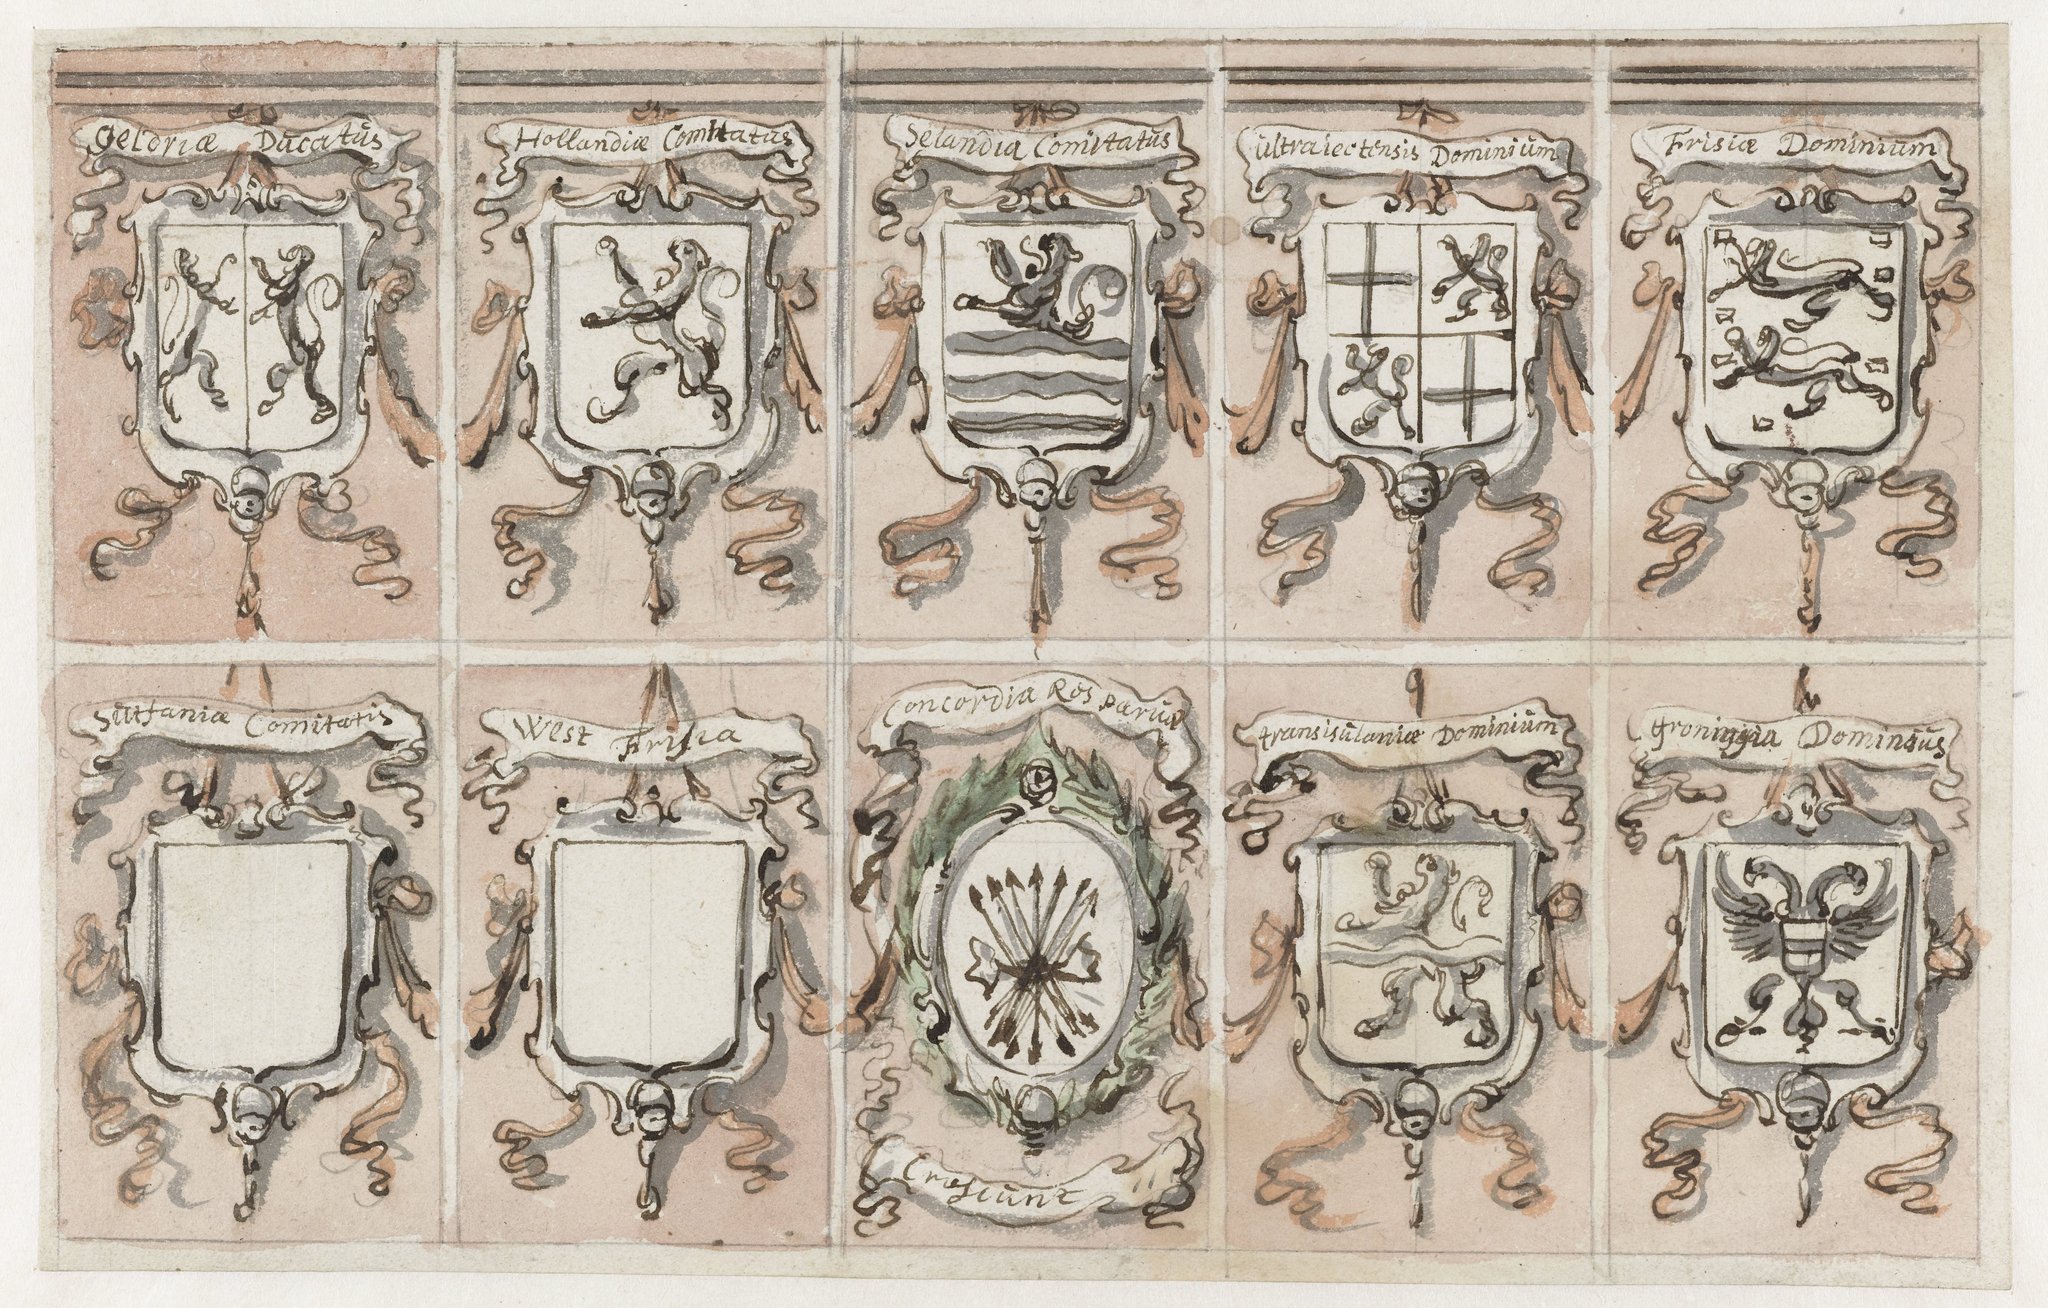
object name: drawing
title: Wapens van de Zeven Provinciën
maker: pieter jansz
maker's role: draughtsman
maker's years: 1602-1672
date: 1630-1672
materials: chalk, graphite, ink, paper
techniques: brush, pen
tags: coat of arms (as symbol of the state, etc.) (+ province; provincial), zeeland, utrecht, holland, guelders